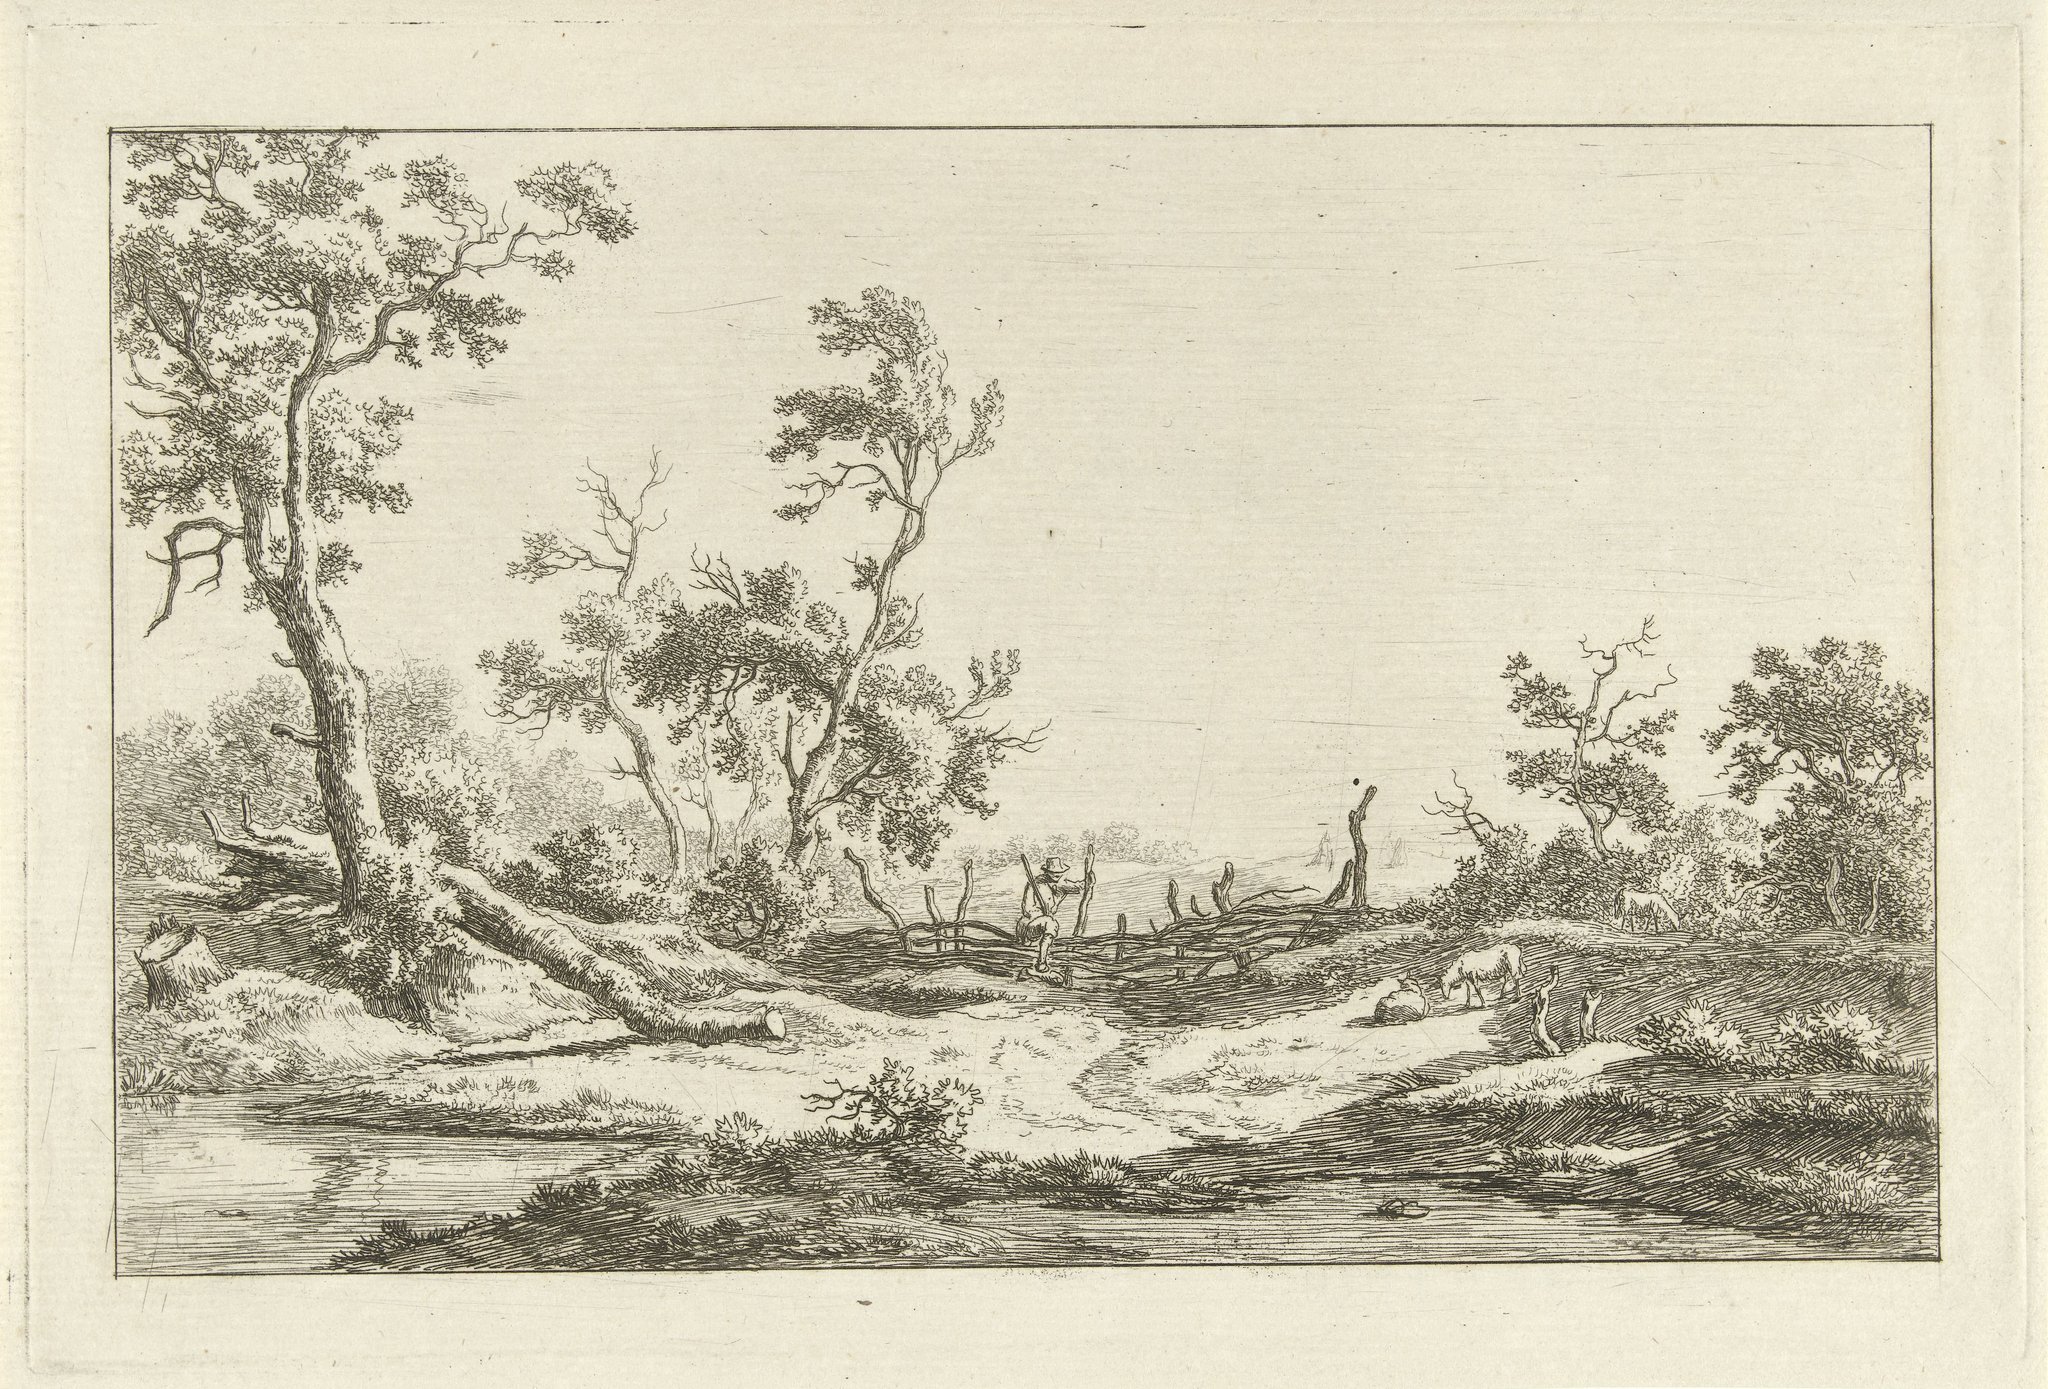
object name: print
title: Landschappen (A-F)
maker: carel lodewijk hansen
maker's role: draughtsman, painter, print maker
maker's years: 1765-1840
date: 1780-1840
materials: paper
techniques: etching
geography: netherlands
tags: landscapes (+ landscape with figures, staffage)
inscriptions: collector's mark: Lugt 2228